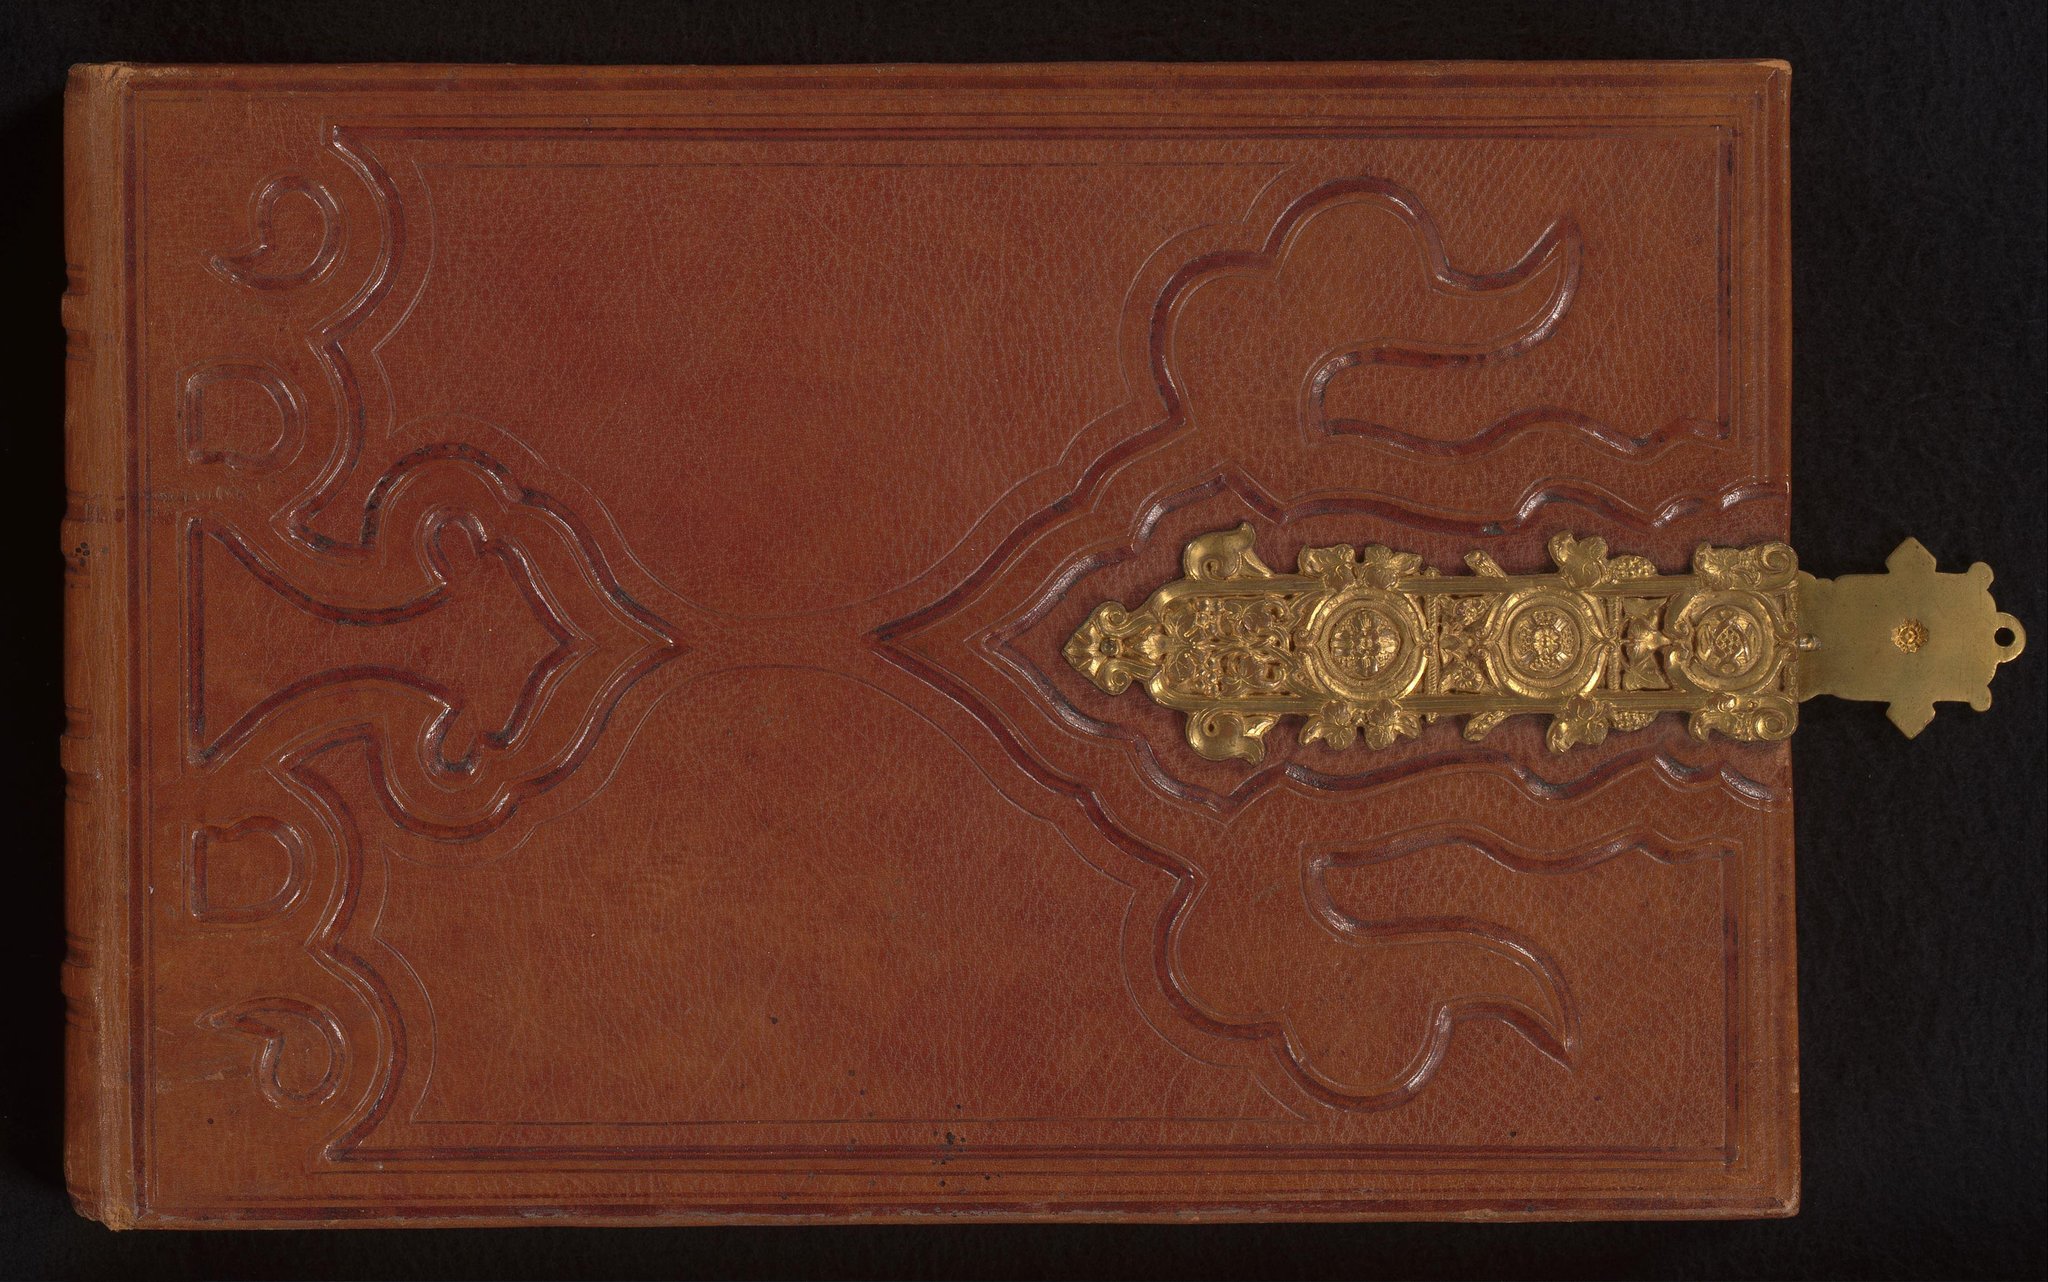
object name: photograph album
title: Fotoalbum (leeg)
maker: Anonymous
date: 1860-1900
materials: cardboard, leather, metal, paper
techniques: color on snow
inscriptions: collector's mark: ‘DIENST/ VERSPREIDE/ RIJKSKOLLEKTIES/ (...) A 891’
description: Fotoalbum met dertig pagina's met op iedere pagina naast elkaar twee met gepreegde rand omkaderde passe-partouts voor cartes-de-visite.